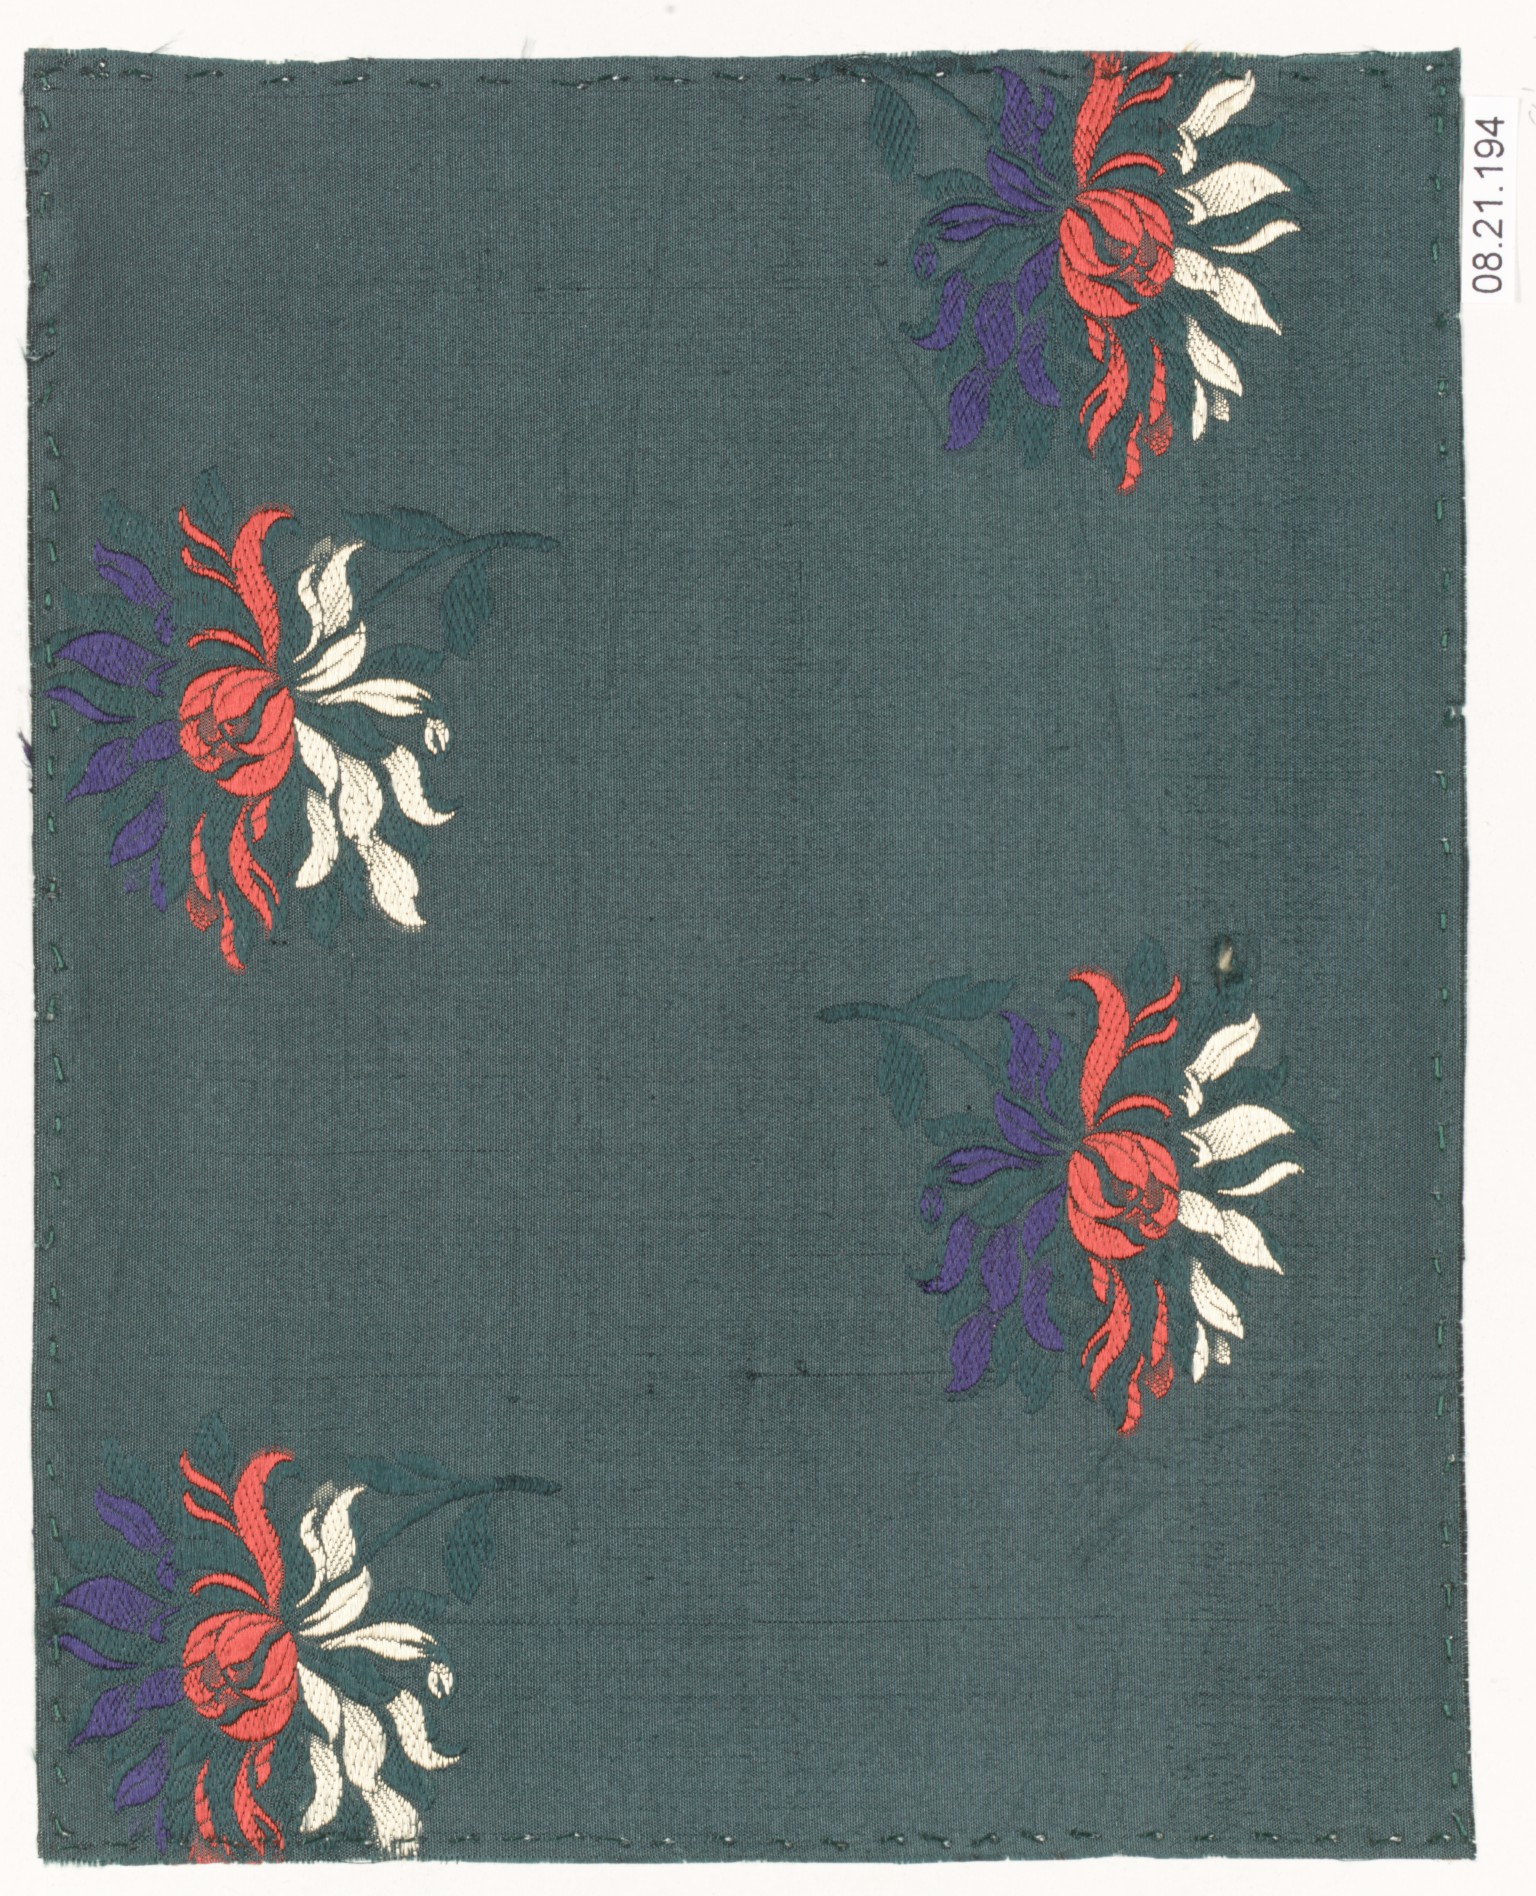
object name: textile sample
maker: Anonymous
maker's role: designer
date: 1900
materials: silk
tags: flowers